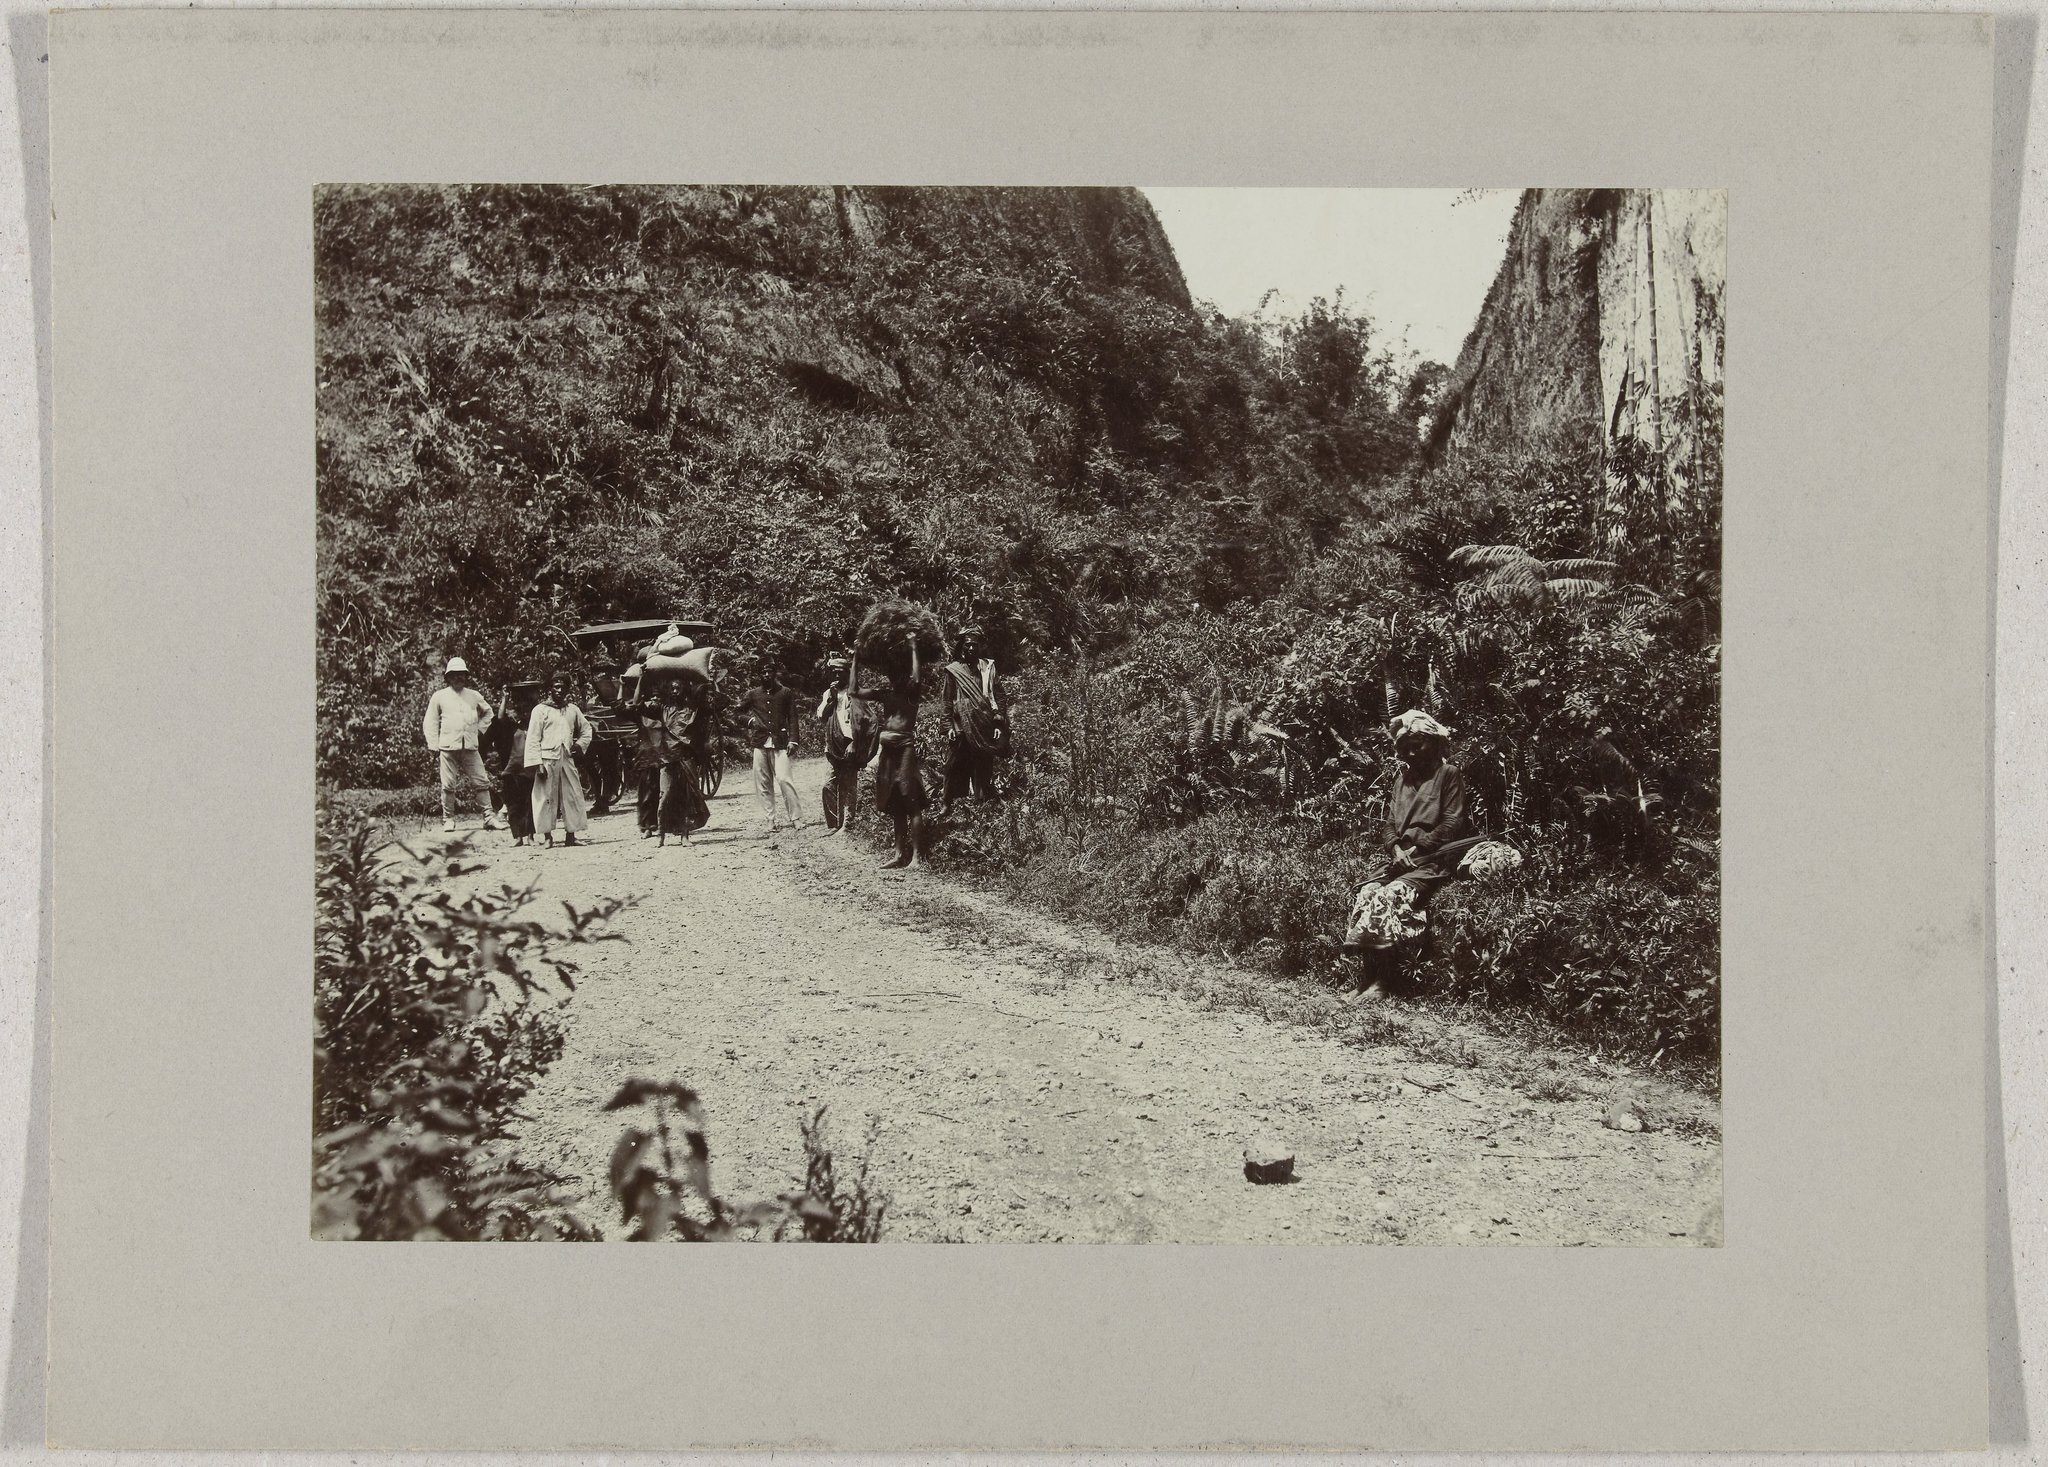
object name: photograph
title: 3. Karbouwengat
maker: Anonymous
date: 1895-1915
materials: cardboard, paper, photographic support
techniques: gelatin silver print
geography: sumatra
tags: karbouwengat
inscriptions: annotation: ‘3. Karbouwengat’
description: Karbouwengat, Sumatra, Nederlands-Indië. Op de weg een gezelschap met een koets en verschillende mensen die op hun hoofd spullen met zich meedragen.